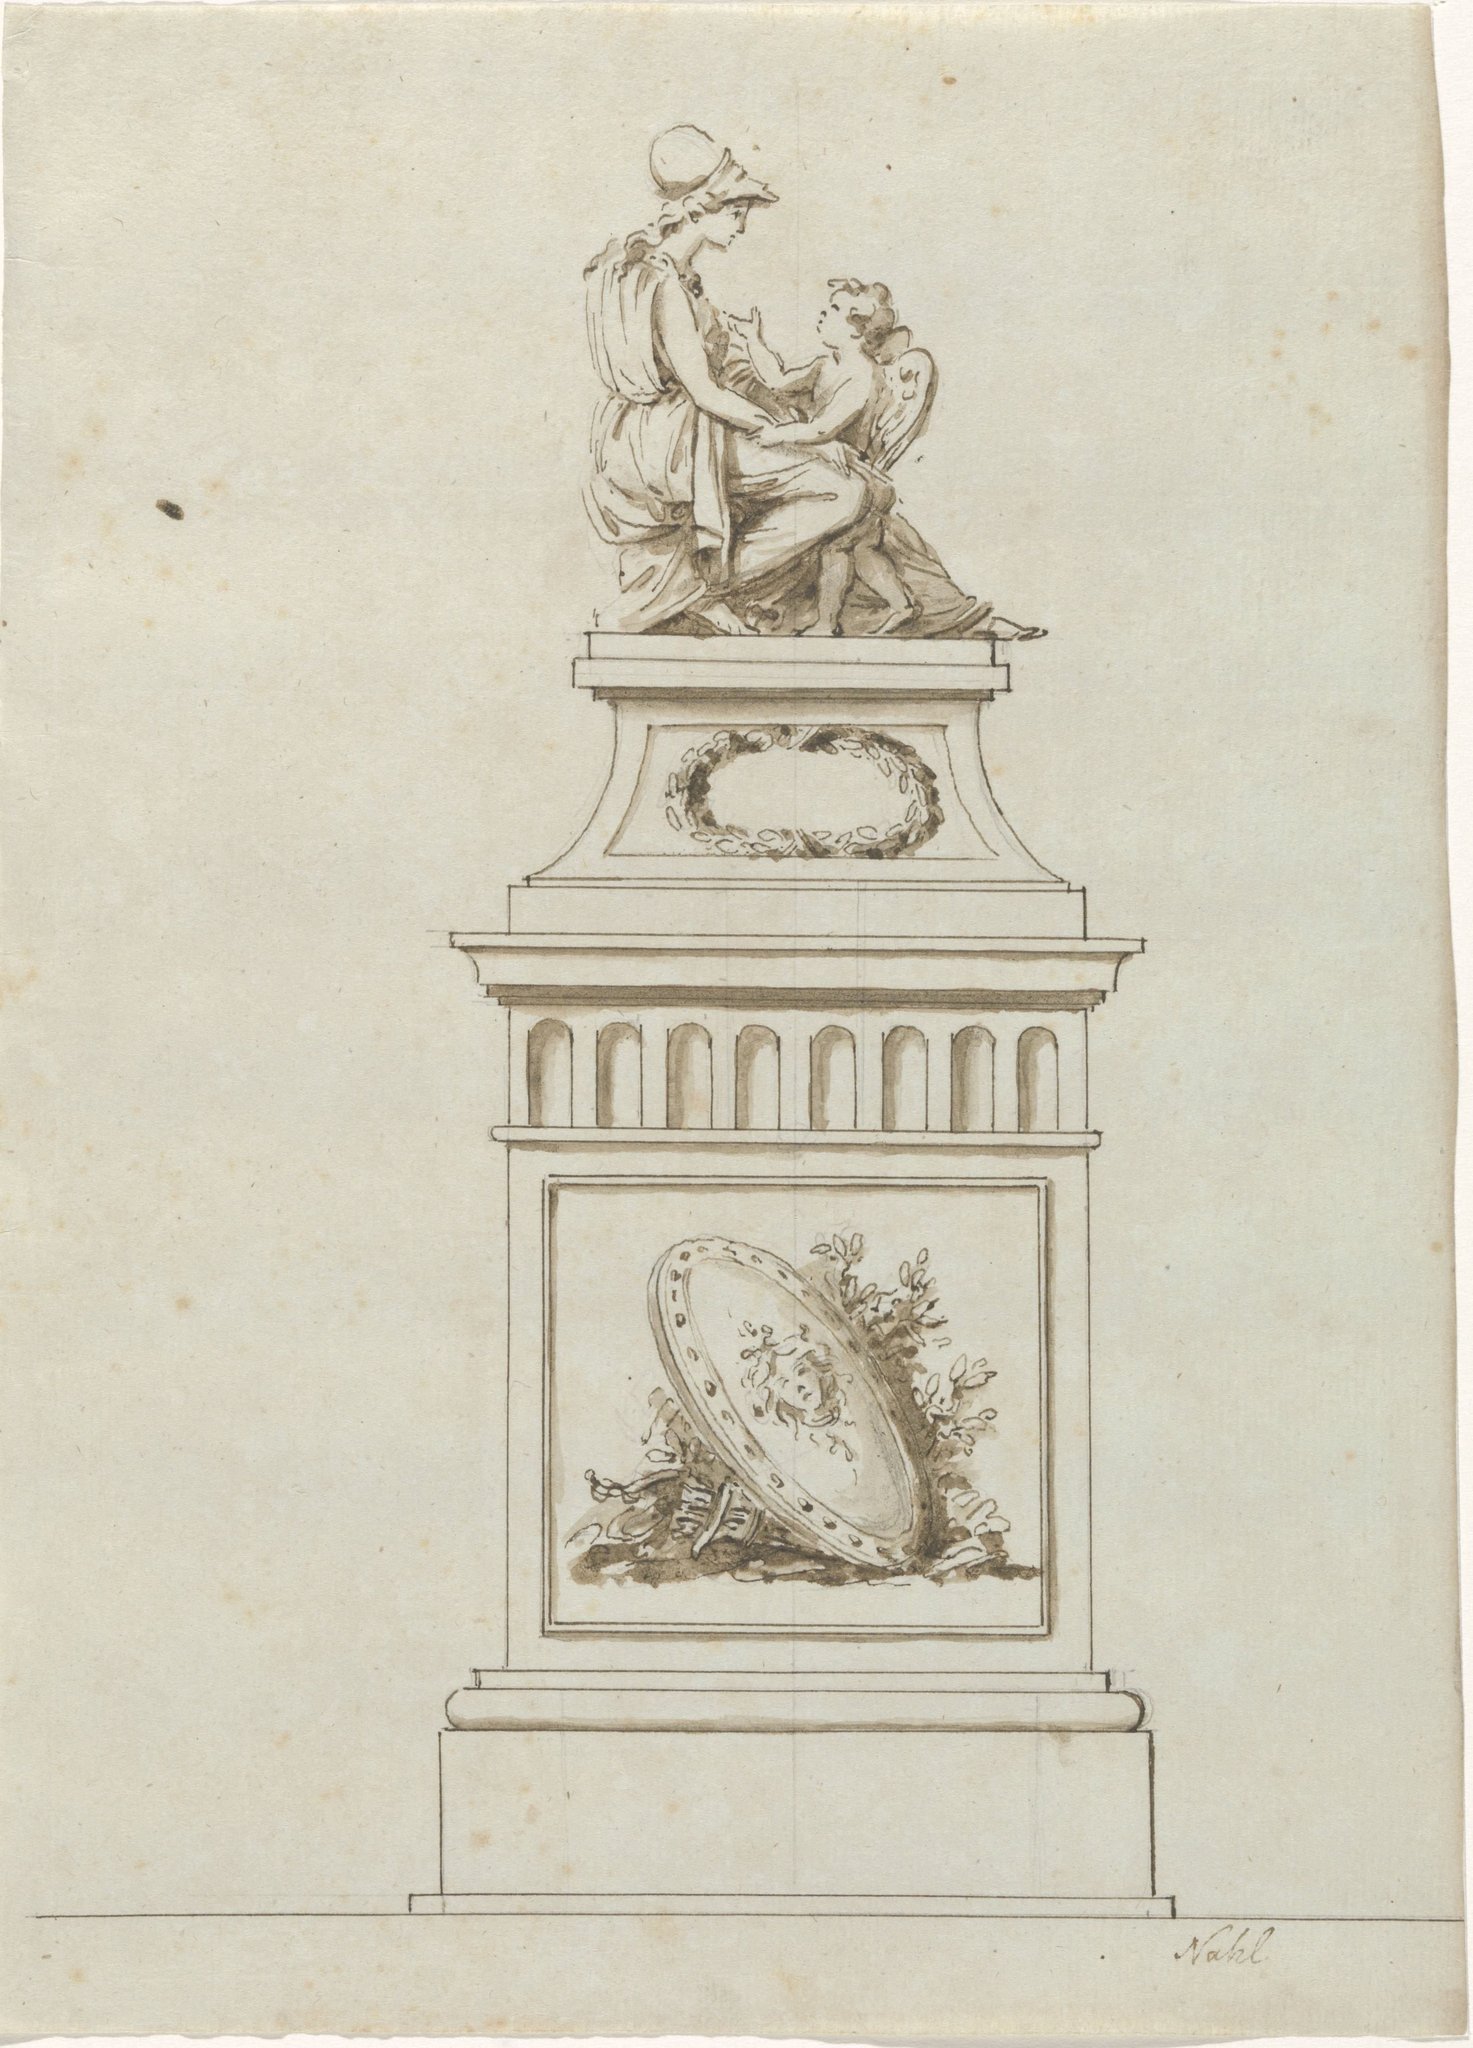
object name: design drawing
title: Ontwerp voor een kachel met Minerva en Amor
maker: johann samuel nahl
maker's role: painter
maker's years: 1728-1813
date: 1775-1785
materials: graphite, ink, paper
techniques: brush, pen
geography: kassel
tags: heating stove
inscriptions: watermark, signature: ‘Nahl’